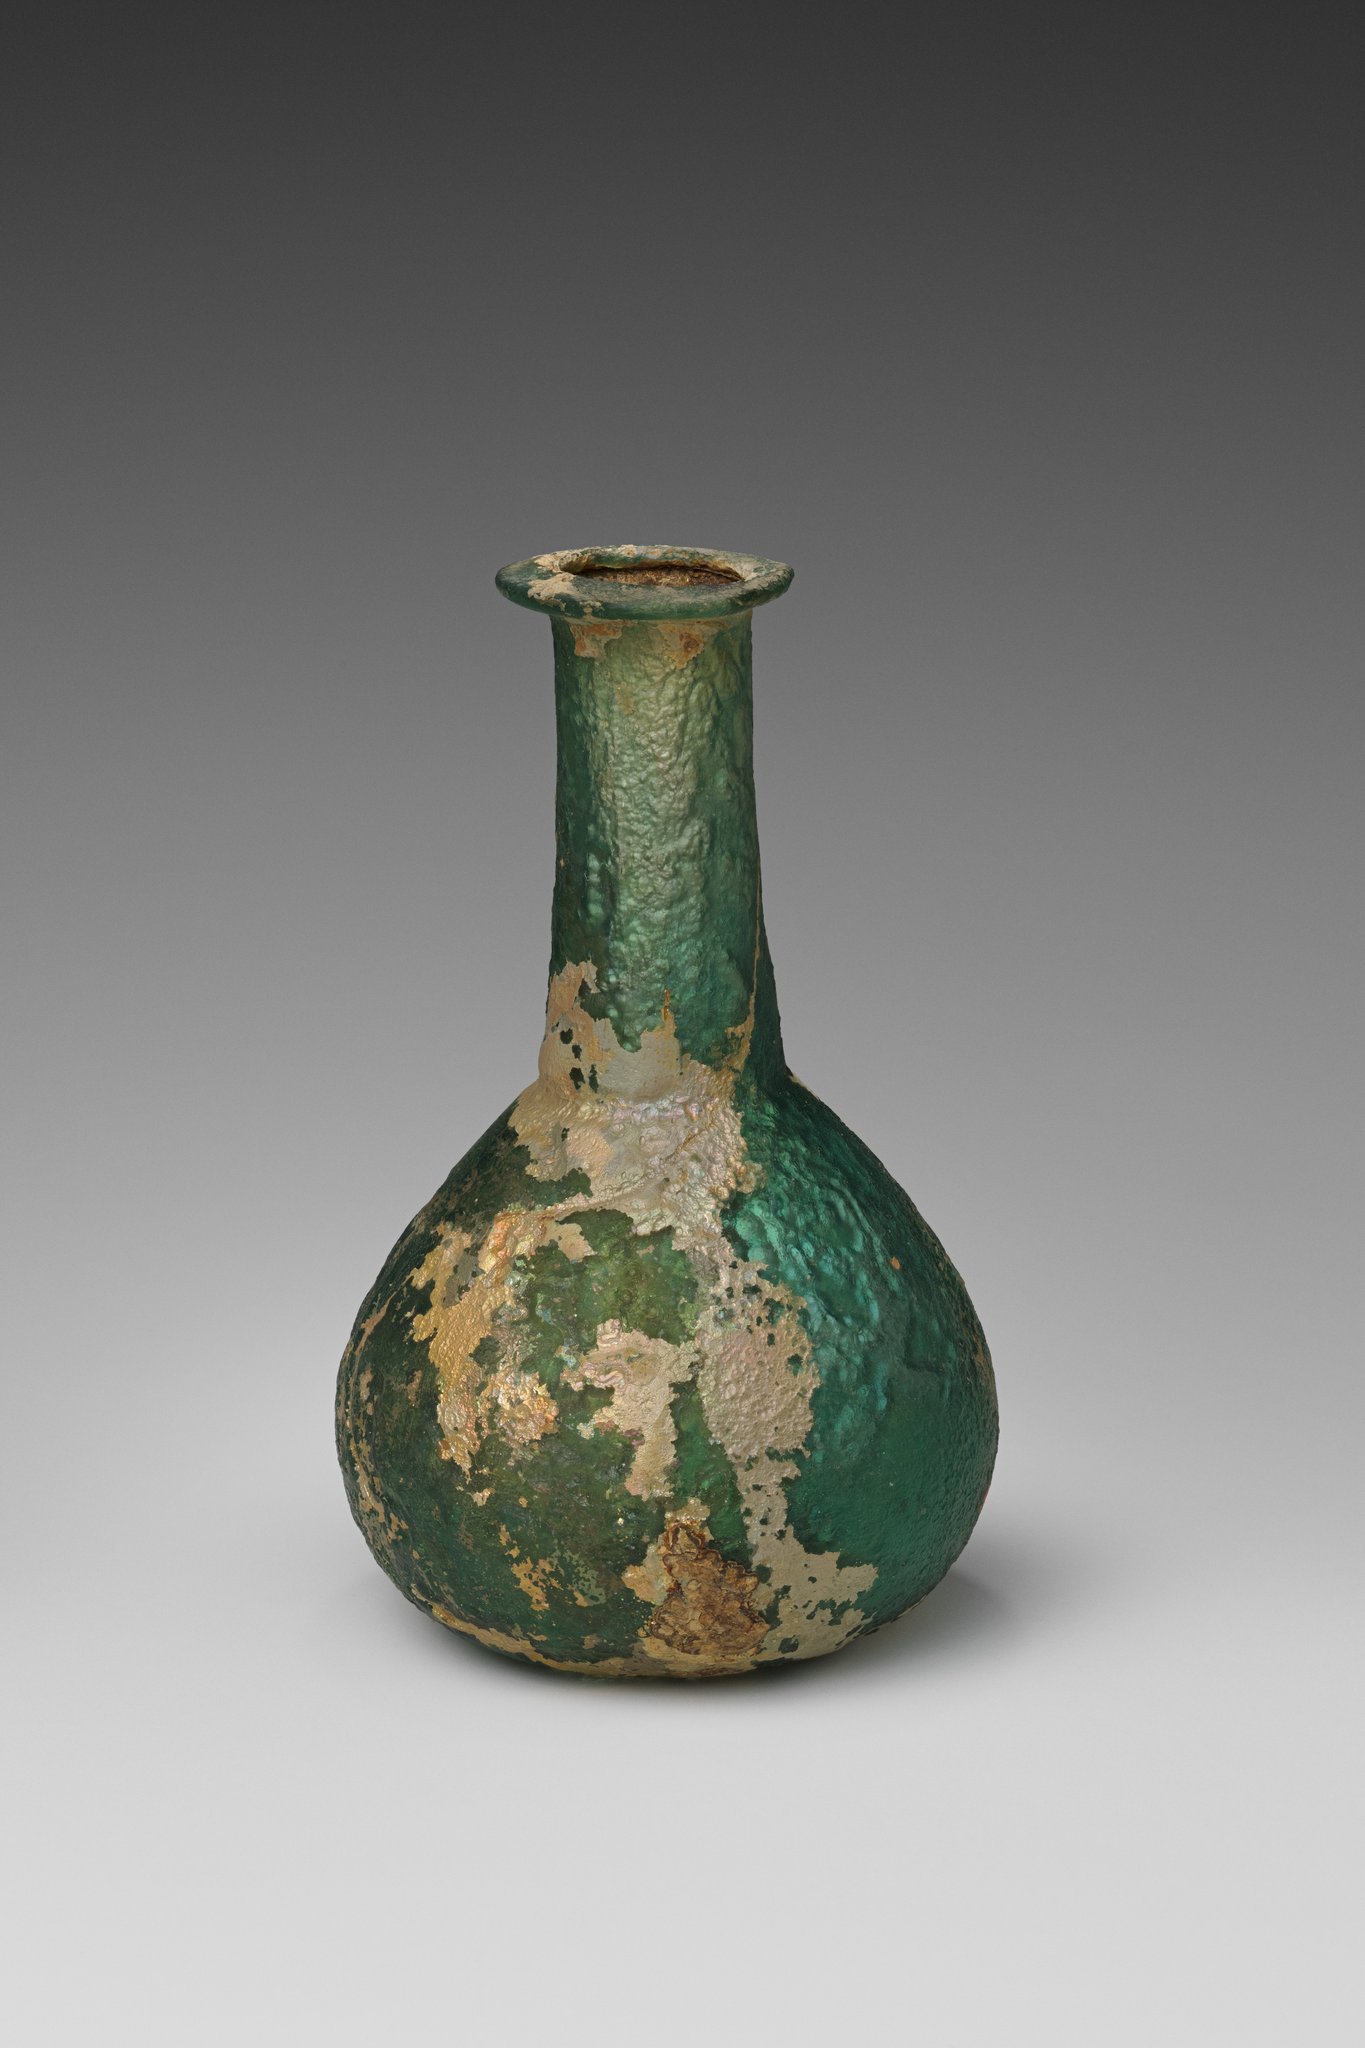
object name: perfume bottle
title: Glass perfume bottle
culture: roman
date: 1-100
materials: glass